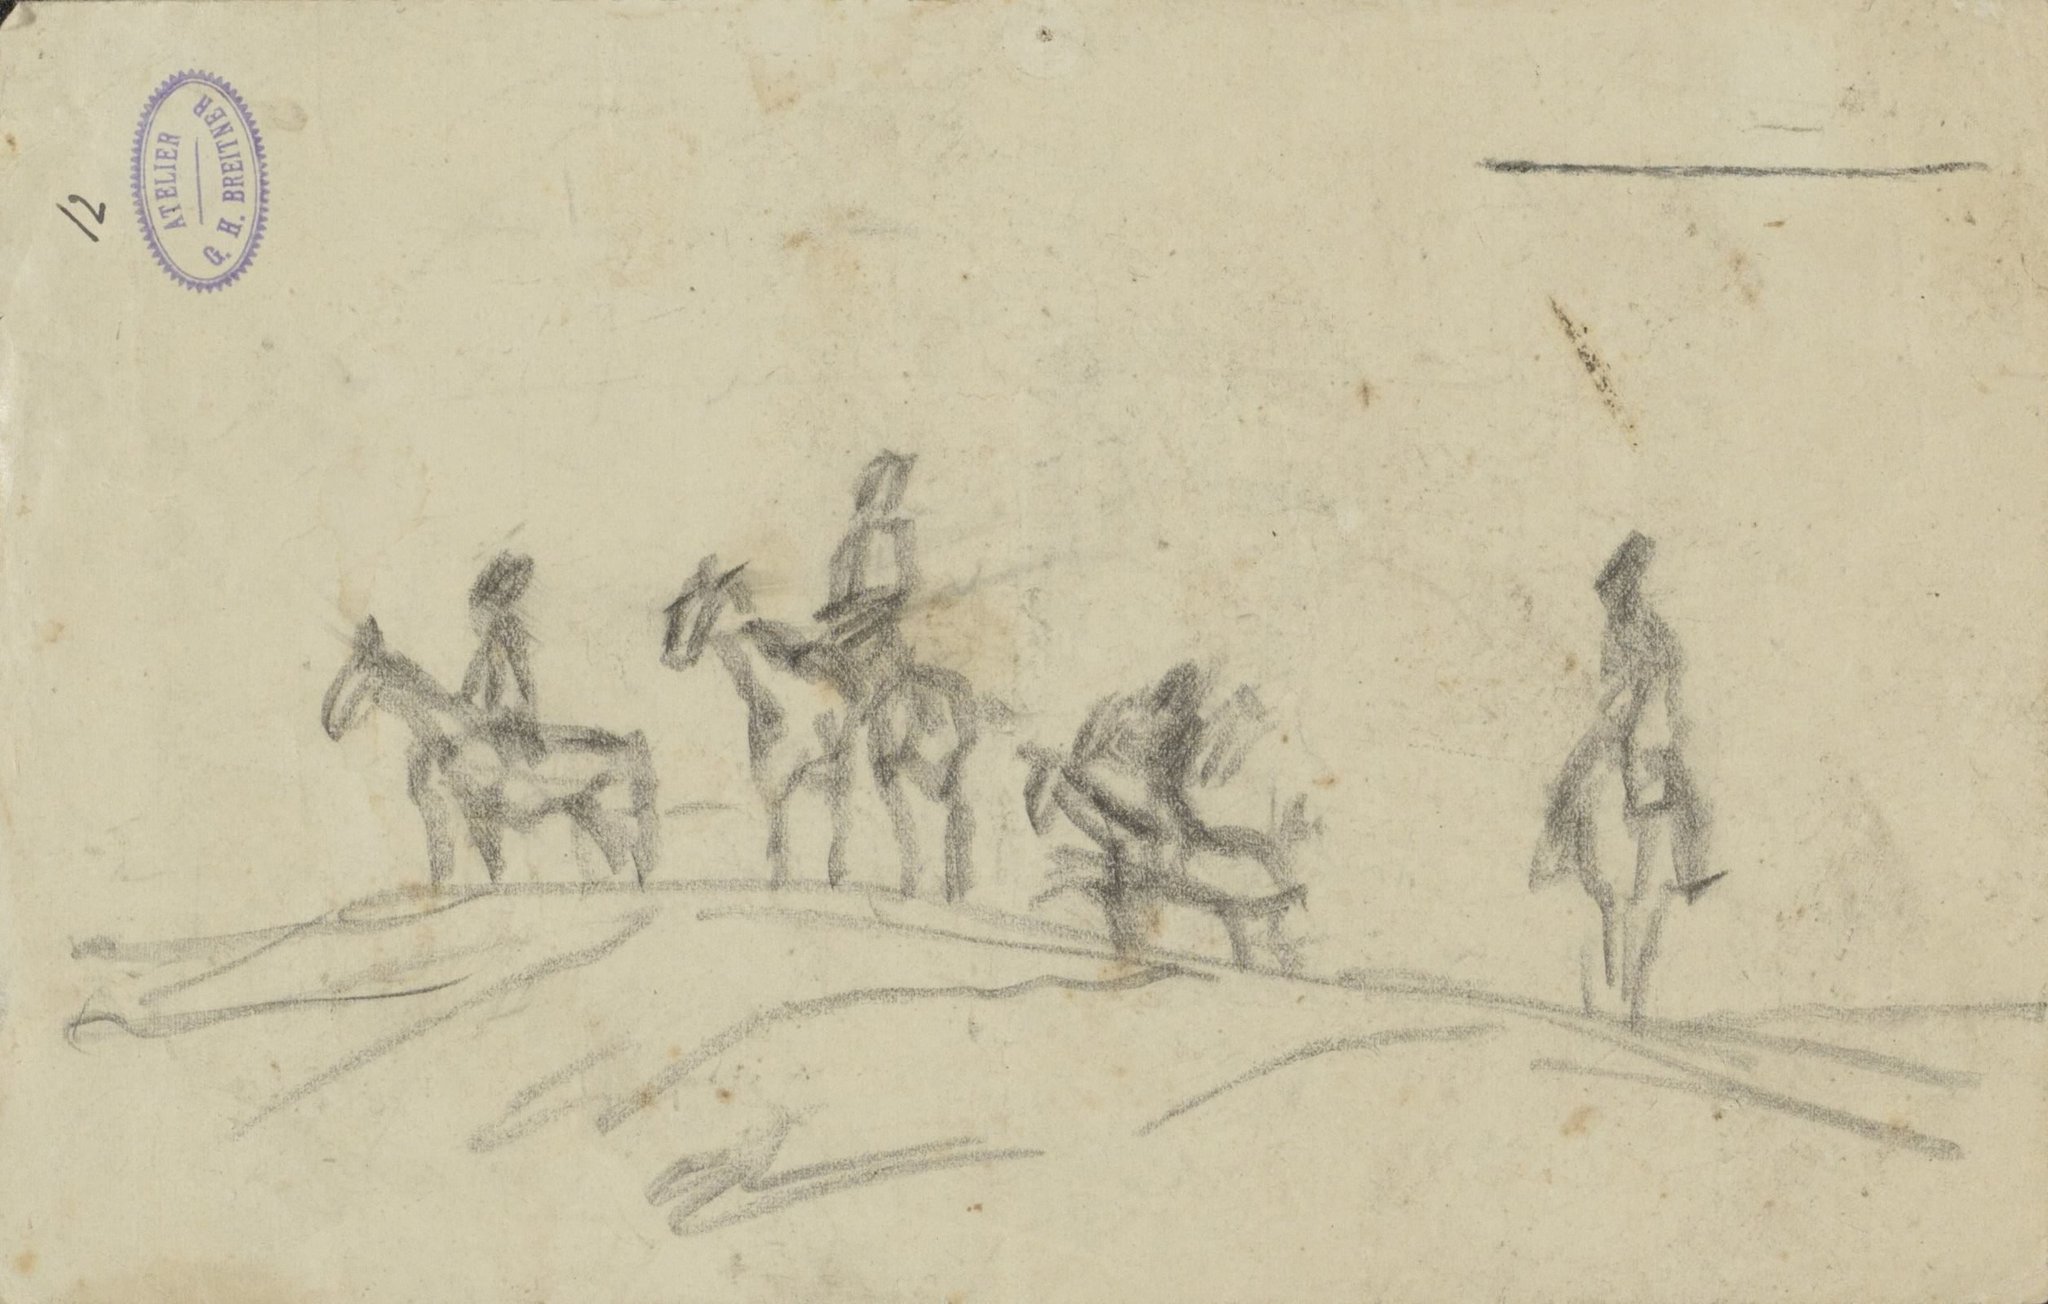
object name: drawing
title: Landschap met cavaleristen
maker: george hendrik breitner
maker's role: draughtsman, painter, print maker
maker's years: 1857-1923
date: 1876-1886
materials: chalk, paper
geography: loosduinen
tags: land forces (+ cavalry, horsemen), dunes (sea not visible); in the dunes (+ landscape with figures, staffage)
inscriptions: workshop stamp: Lugt 291d, collector's mark: Lugt 2228, annotation: ‘[...]’